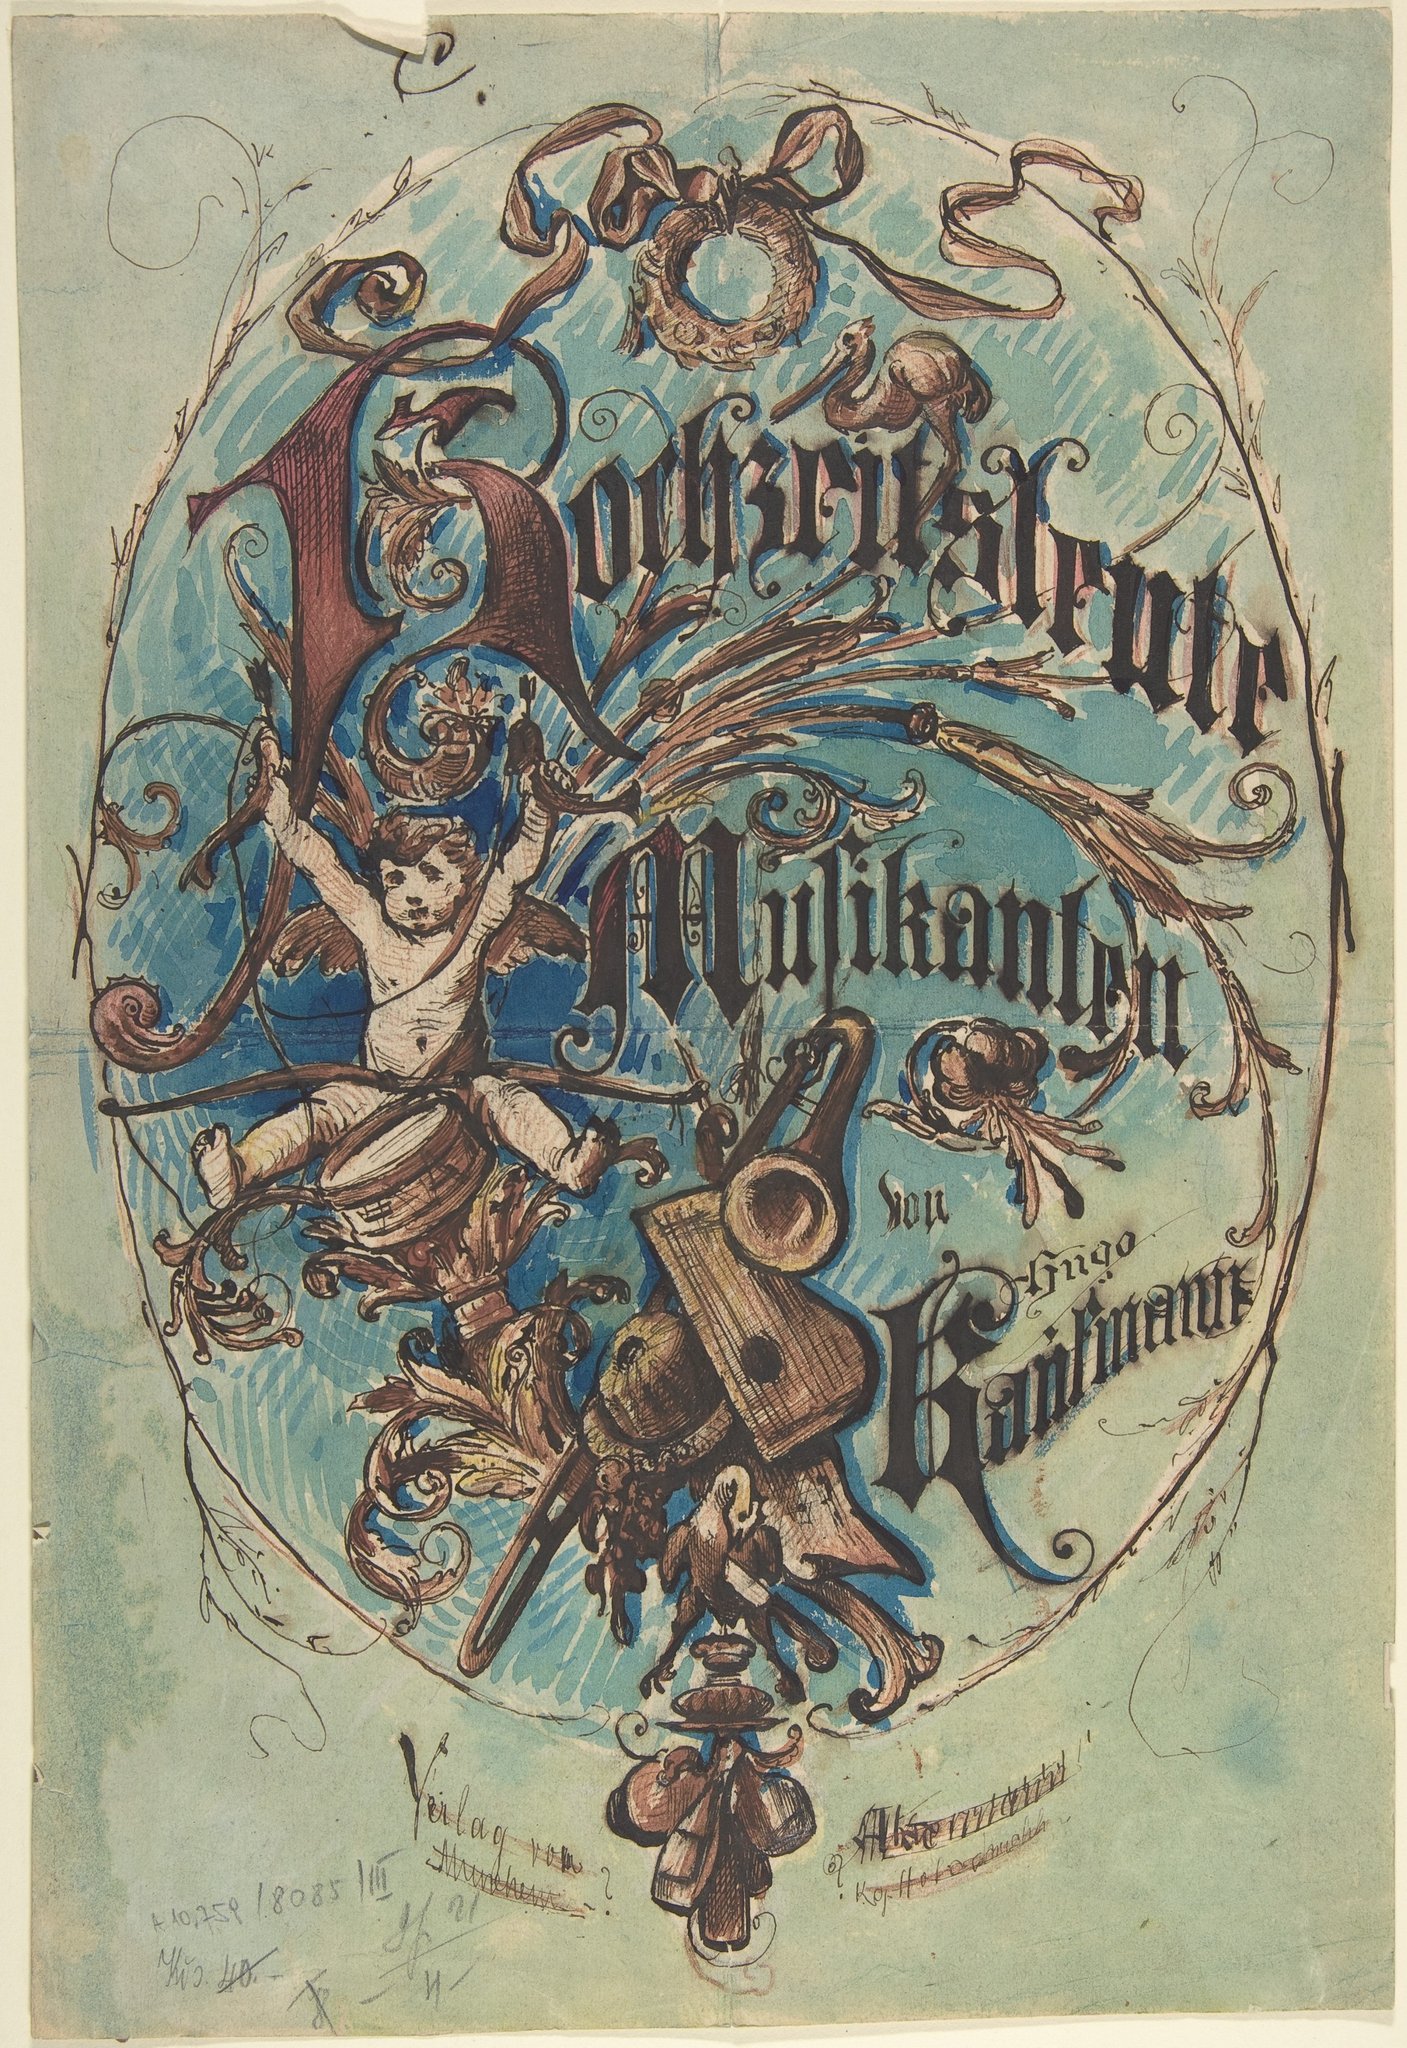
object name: drawing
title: Design for a Title Page Sheet Music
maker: anonymous, german, 19th century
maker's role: artist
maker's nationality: german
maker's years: 1800-1899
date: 1801-1900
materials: chalk, ink, paper, watercolor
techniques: brush, pen, wash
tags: musical instruments,birds